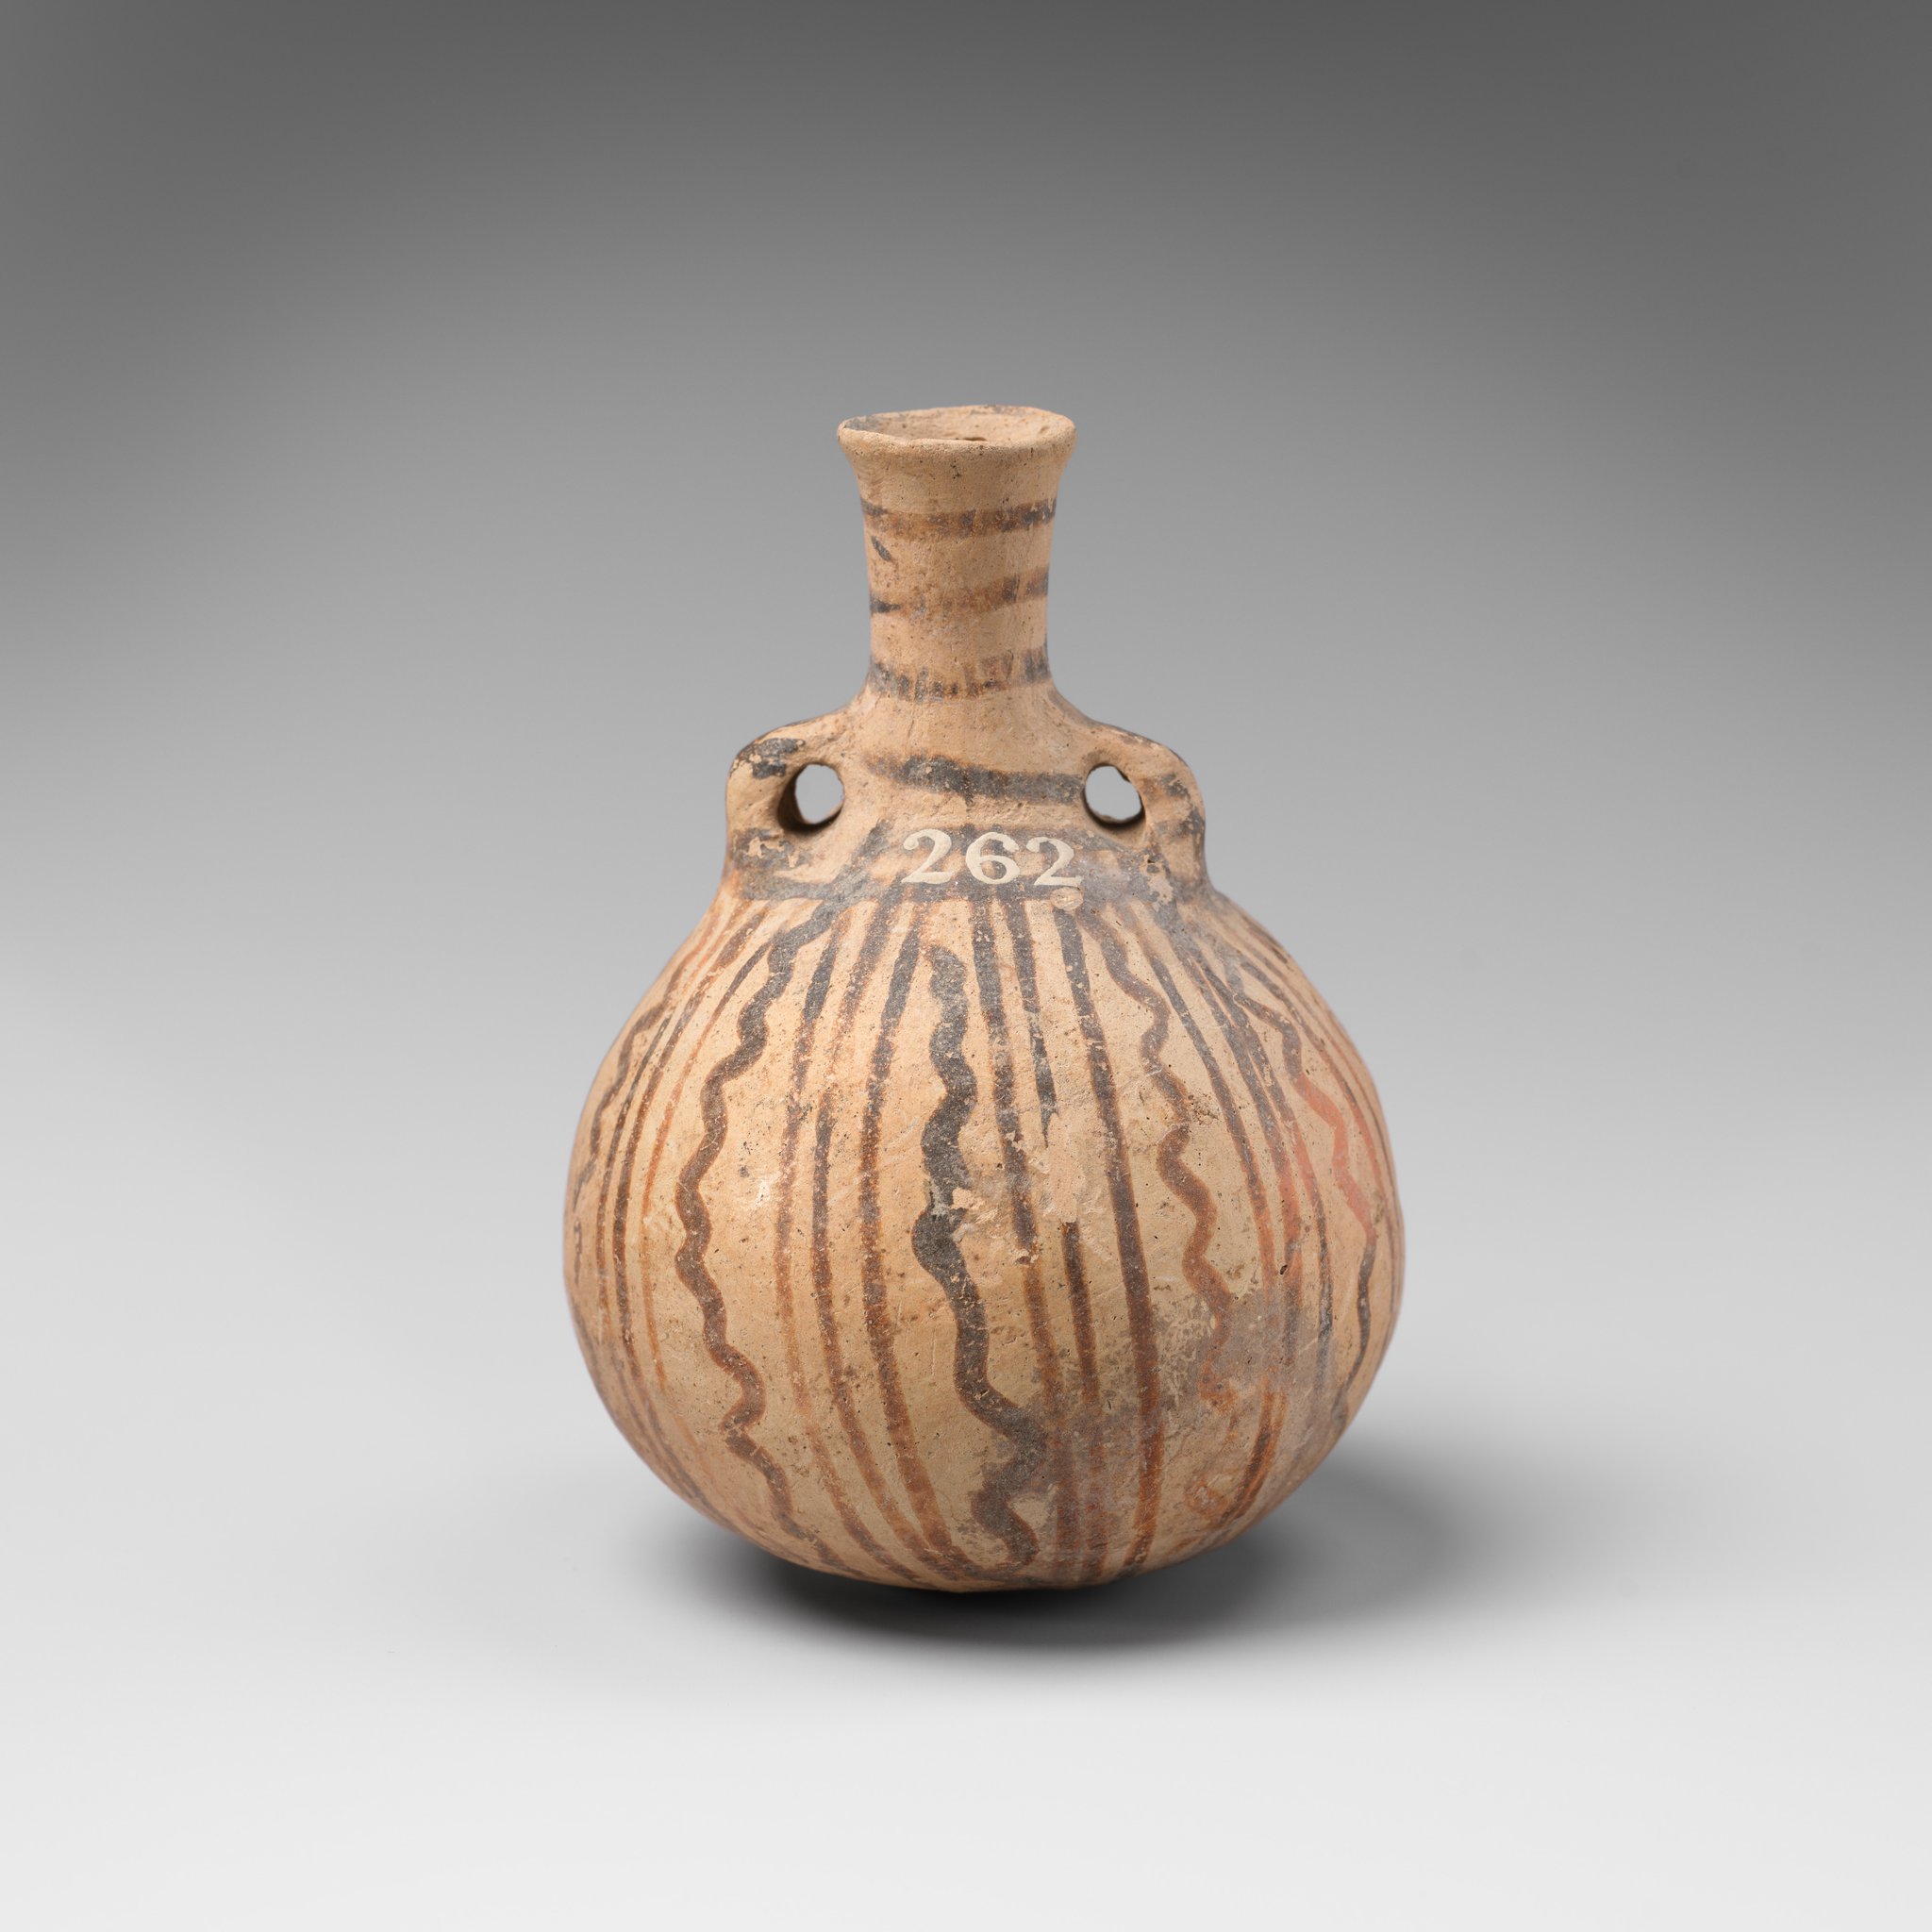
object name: juglet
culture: cypriot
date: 1900-1600 BCE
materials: terracotta